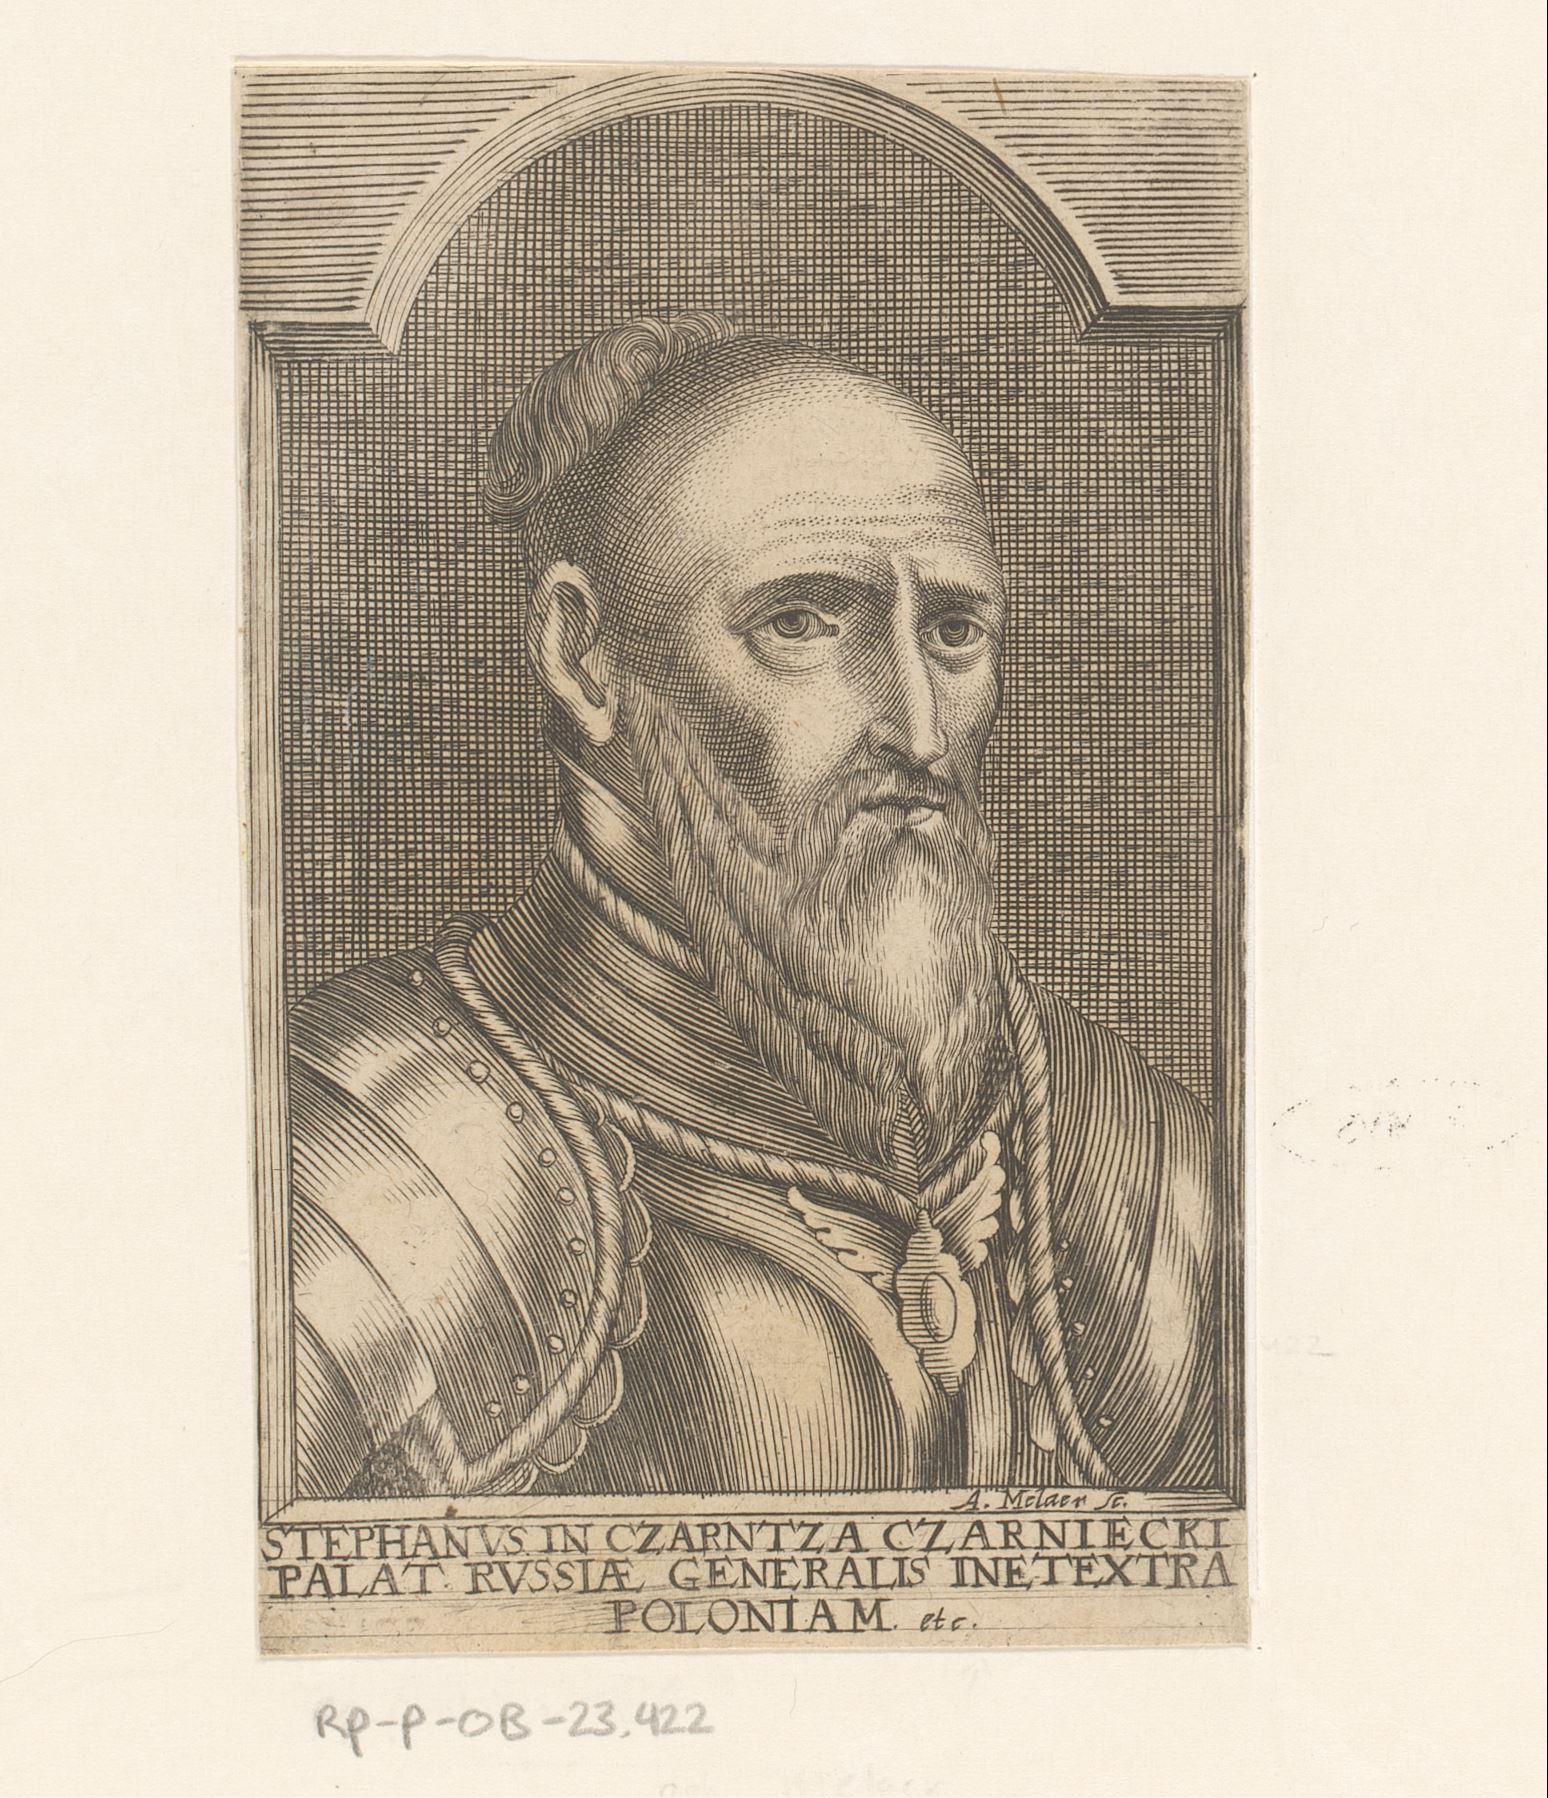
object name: print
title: Portret van Stefan Czarniecki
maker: adriaen millaert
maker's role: print maker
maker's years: 1633-1667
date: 1643-1667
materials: paper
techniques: engraving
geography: antwerp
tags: commander-in-chief, general, marshal, historical persons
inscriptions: collector's mark: Lugt 2228